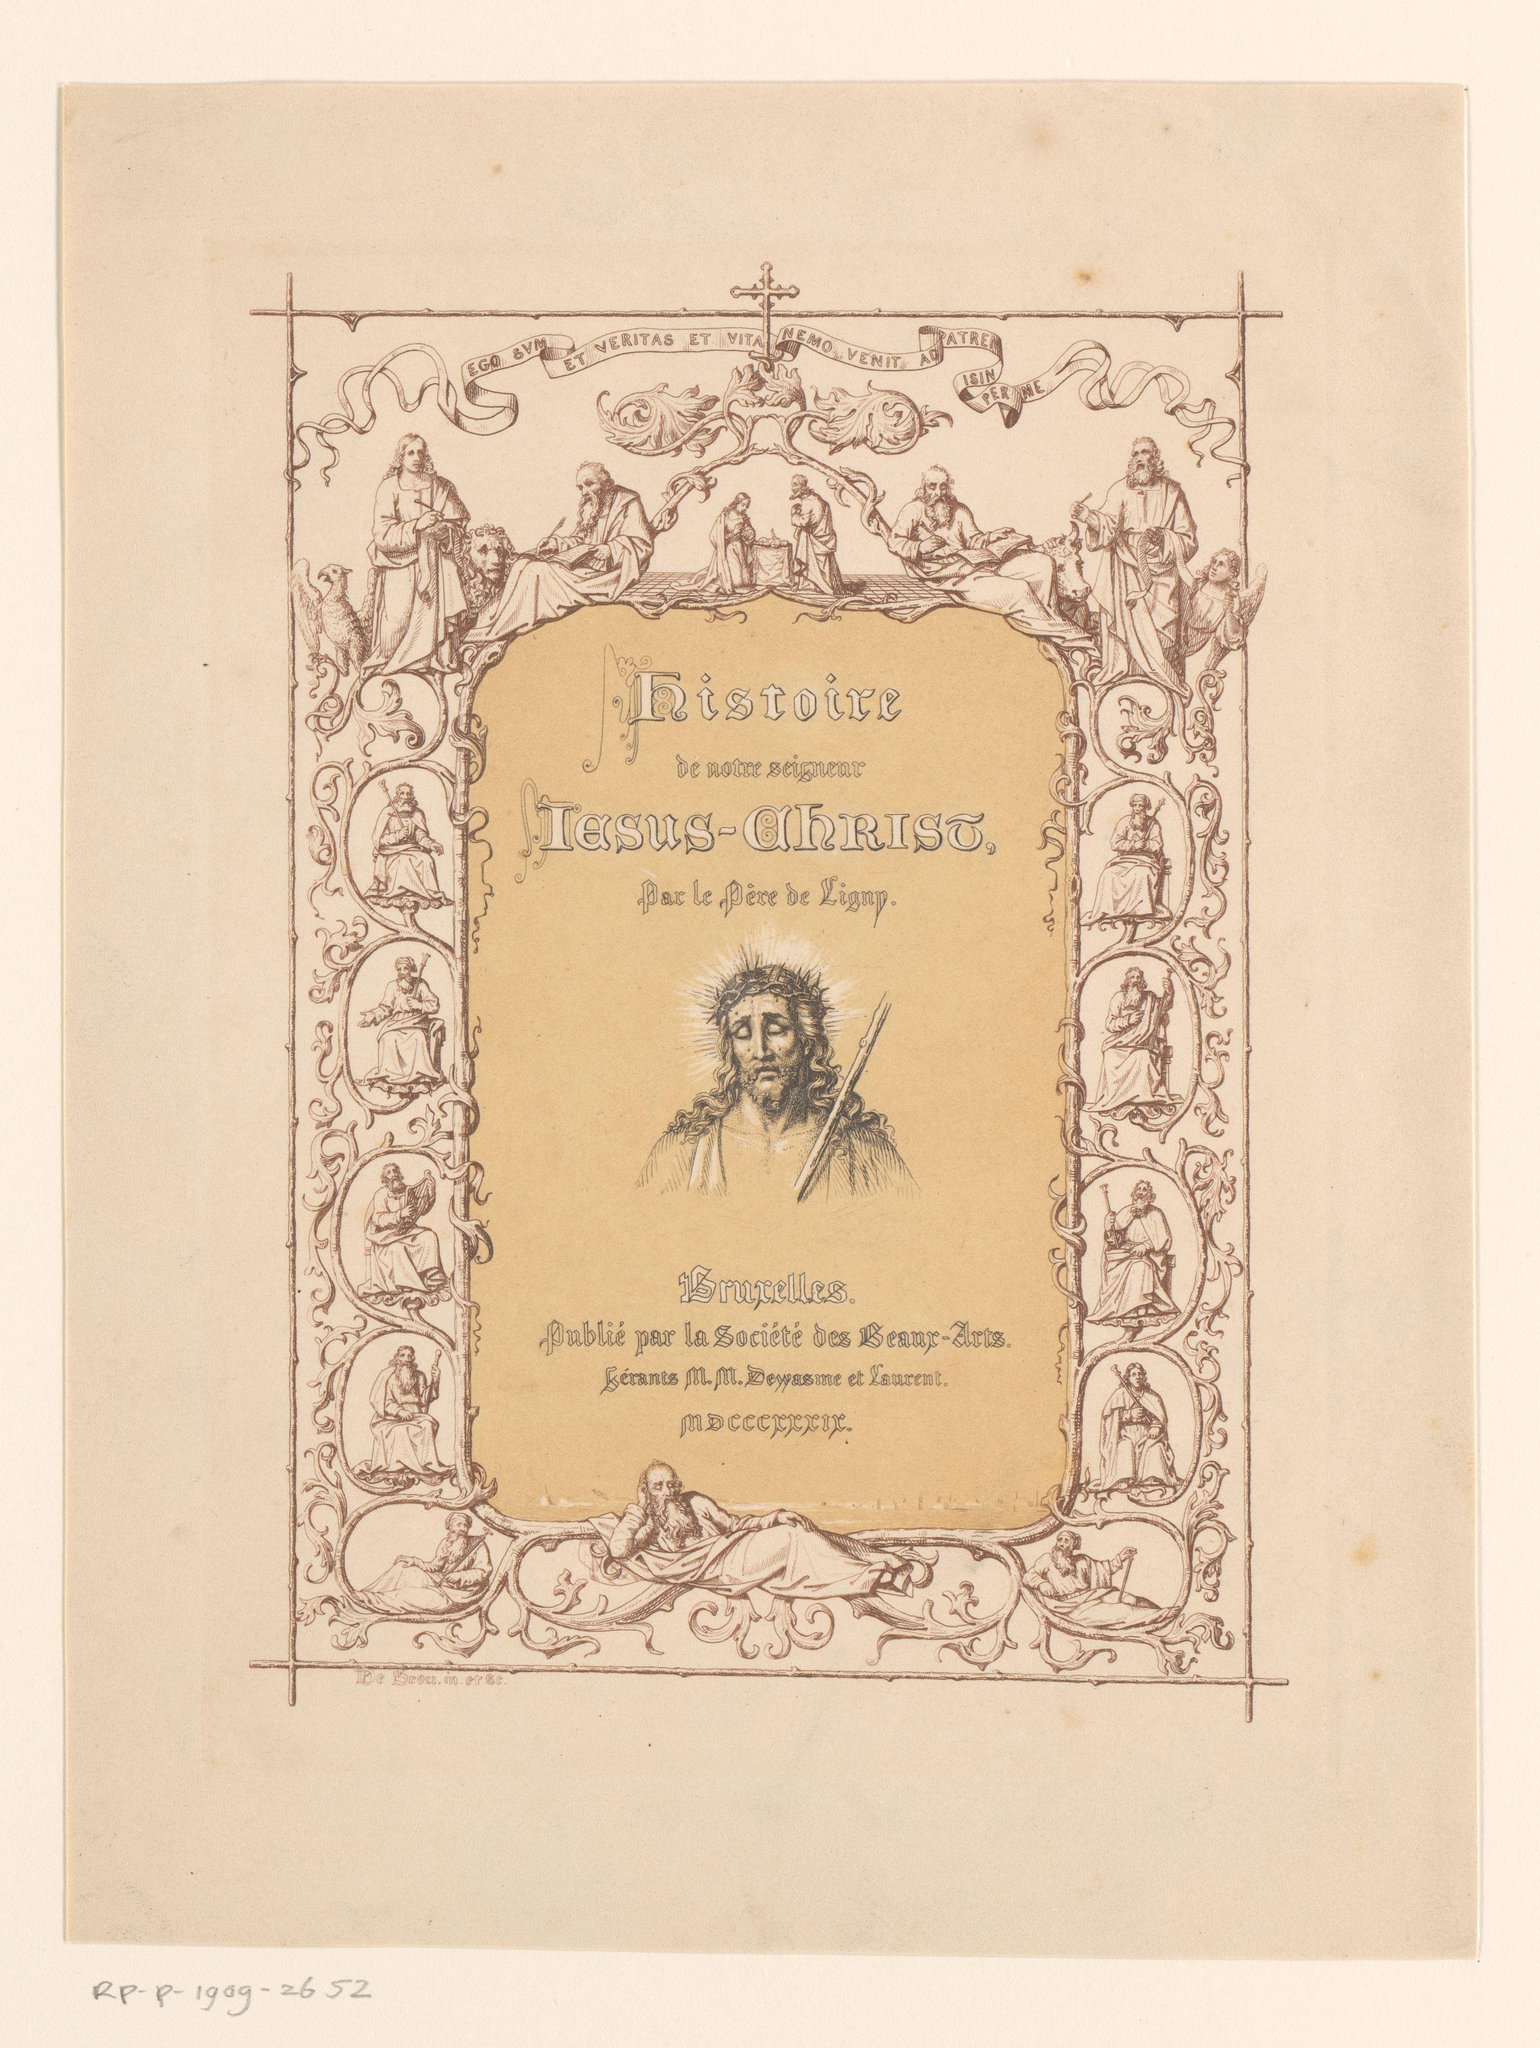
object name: titelblad, titelpagina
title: Buste van Christus met doornenkrans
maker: charles de brou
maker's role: print maker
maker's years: 1811-1877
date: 1839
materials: paper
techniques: tone lithography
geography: brussels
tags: christ suffering (with crown of thorns, head usually turned sidewards), adoration of the christ-child ~ christ's birth, the evangelists writing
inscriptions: collector's mark: Lugt 1485, collector's mark: Lugt 2228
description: Titelpagina voor: Ligny, P. Histoire de notre seigneur Jesus Christ. Brussel: Societe des Beaux-Arts, 1839.